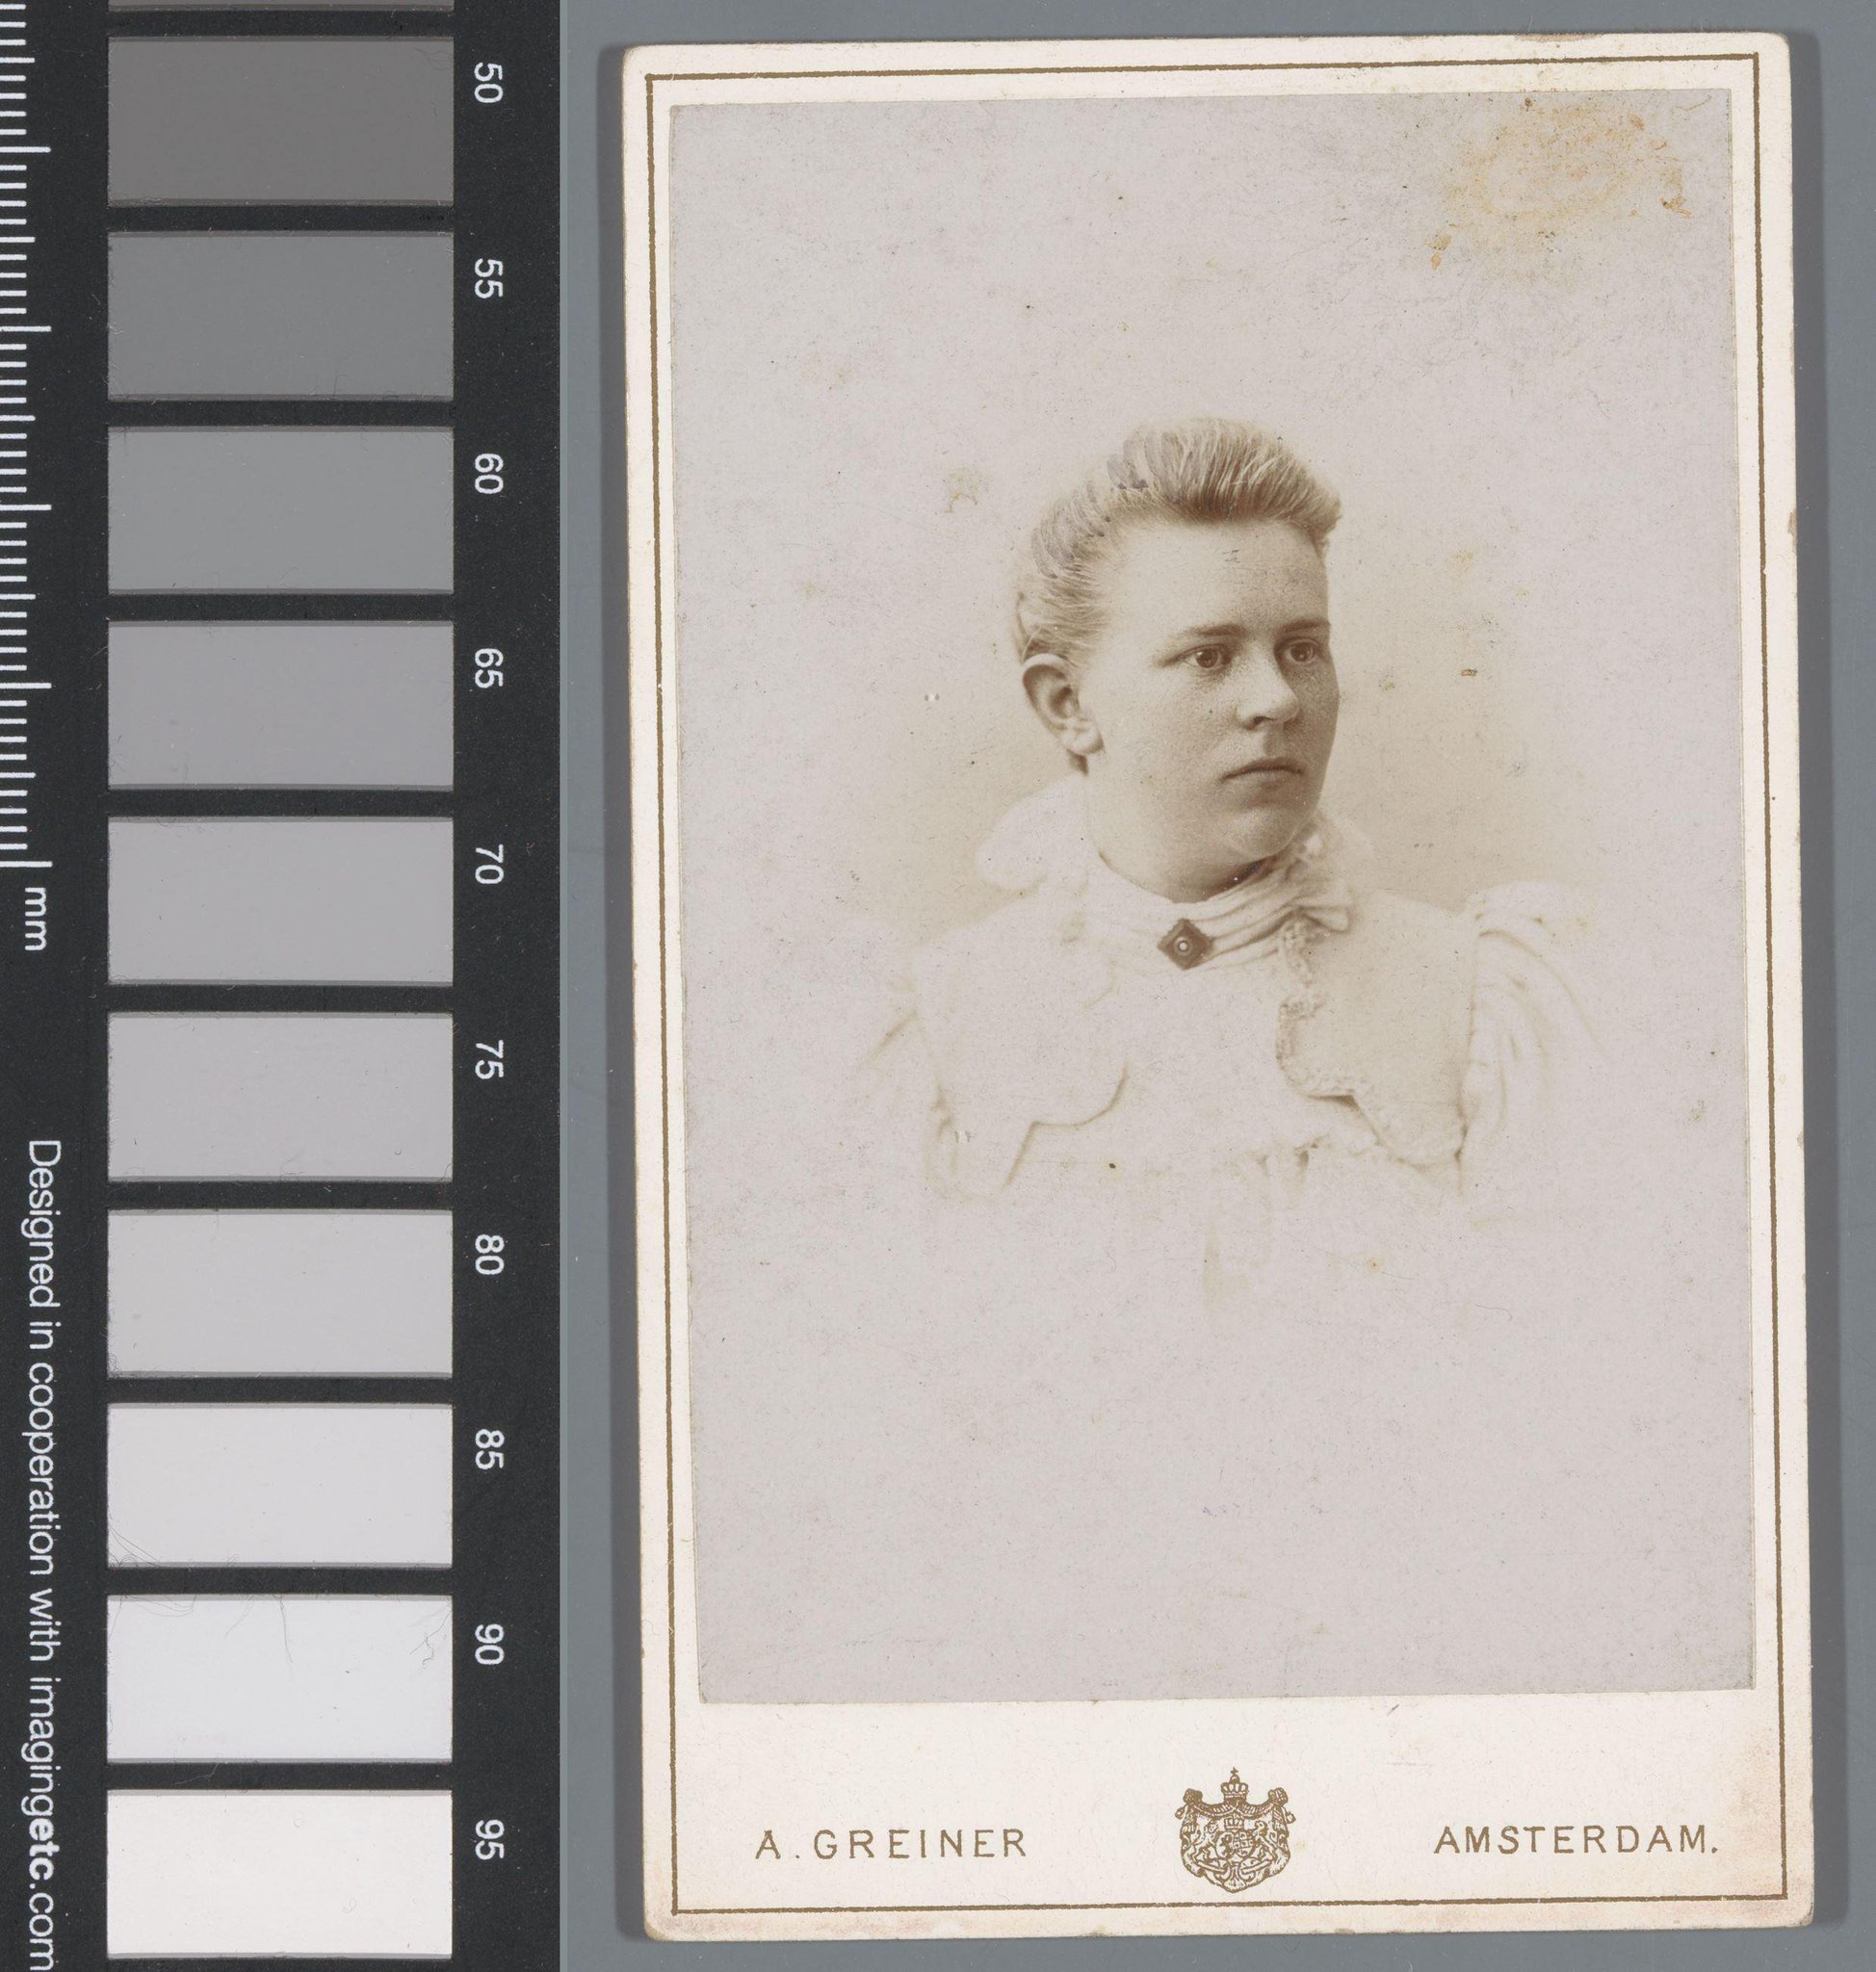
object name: carte de visite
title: Portret van een onbekende vrouw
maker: albert greiner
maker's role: fotograaf, fotostudio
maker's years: 1833-1890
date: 1883-1887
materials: paper, cardboard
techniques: collodion silver print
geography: amsterdam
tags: adult woman, anonymous historical person portrayed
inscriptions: address: ‘AMSTERDAM/ NIEUWENDIJK 89.’, inscription: ‘Specialiteit in Vergrootingen.’